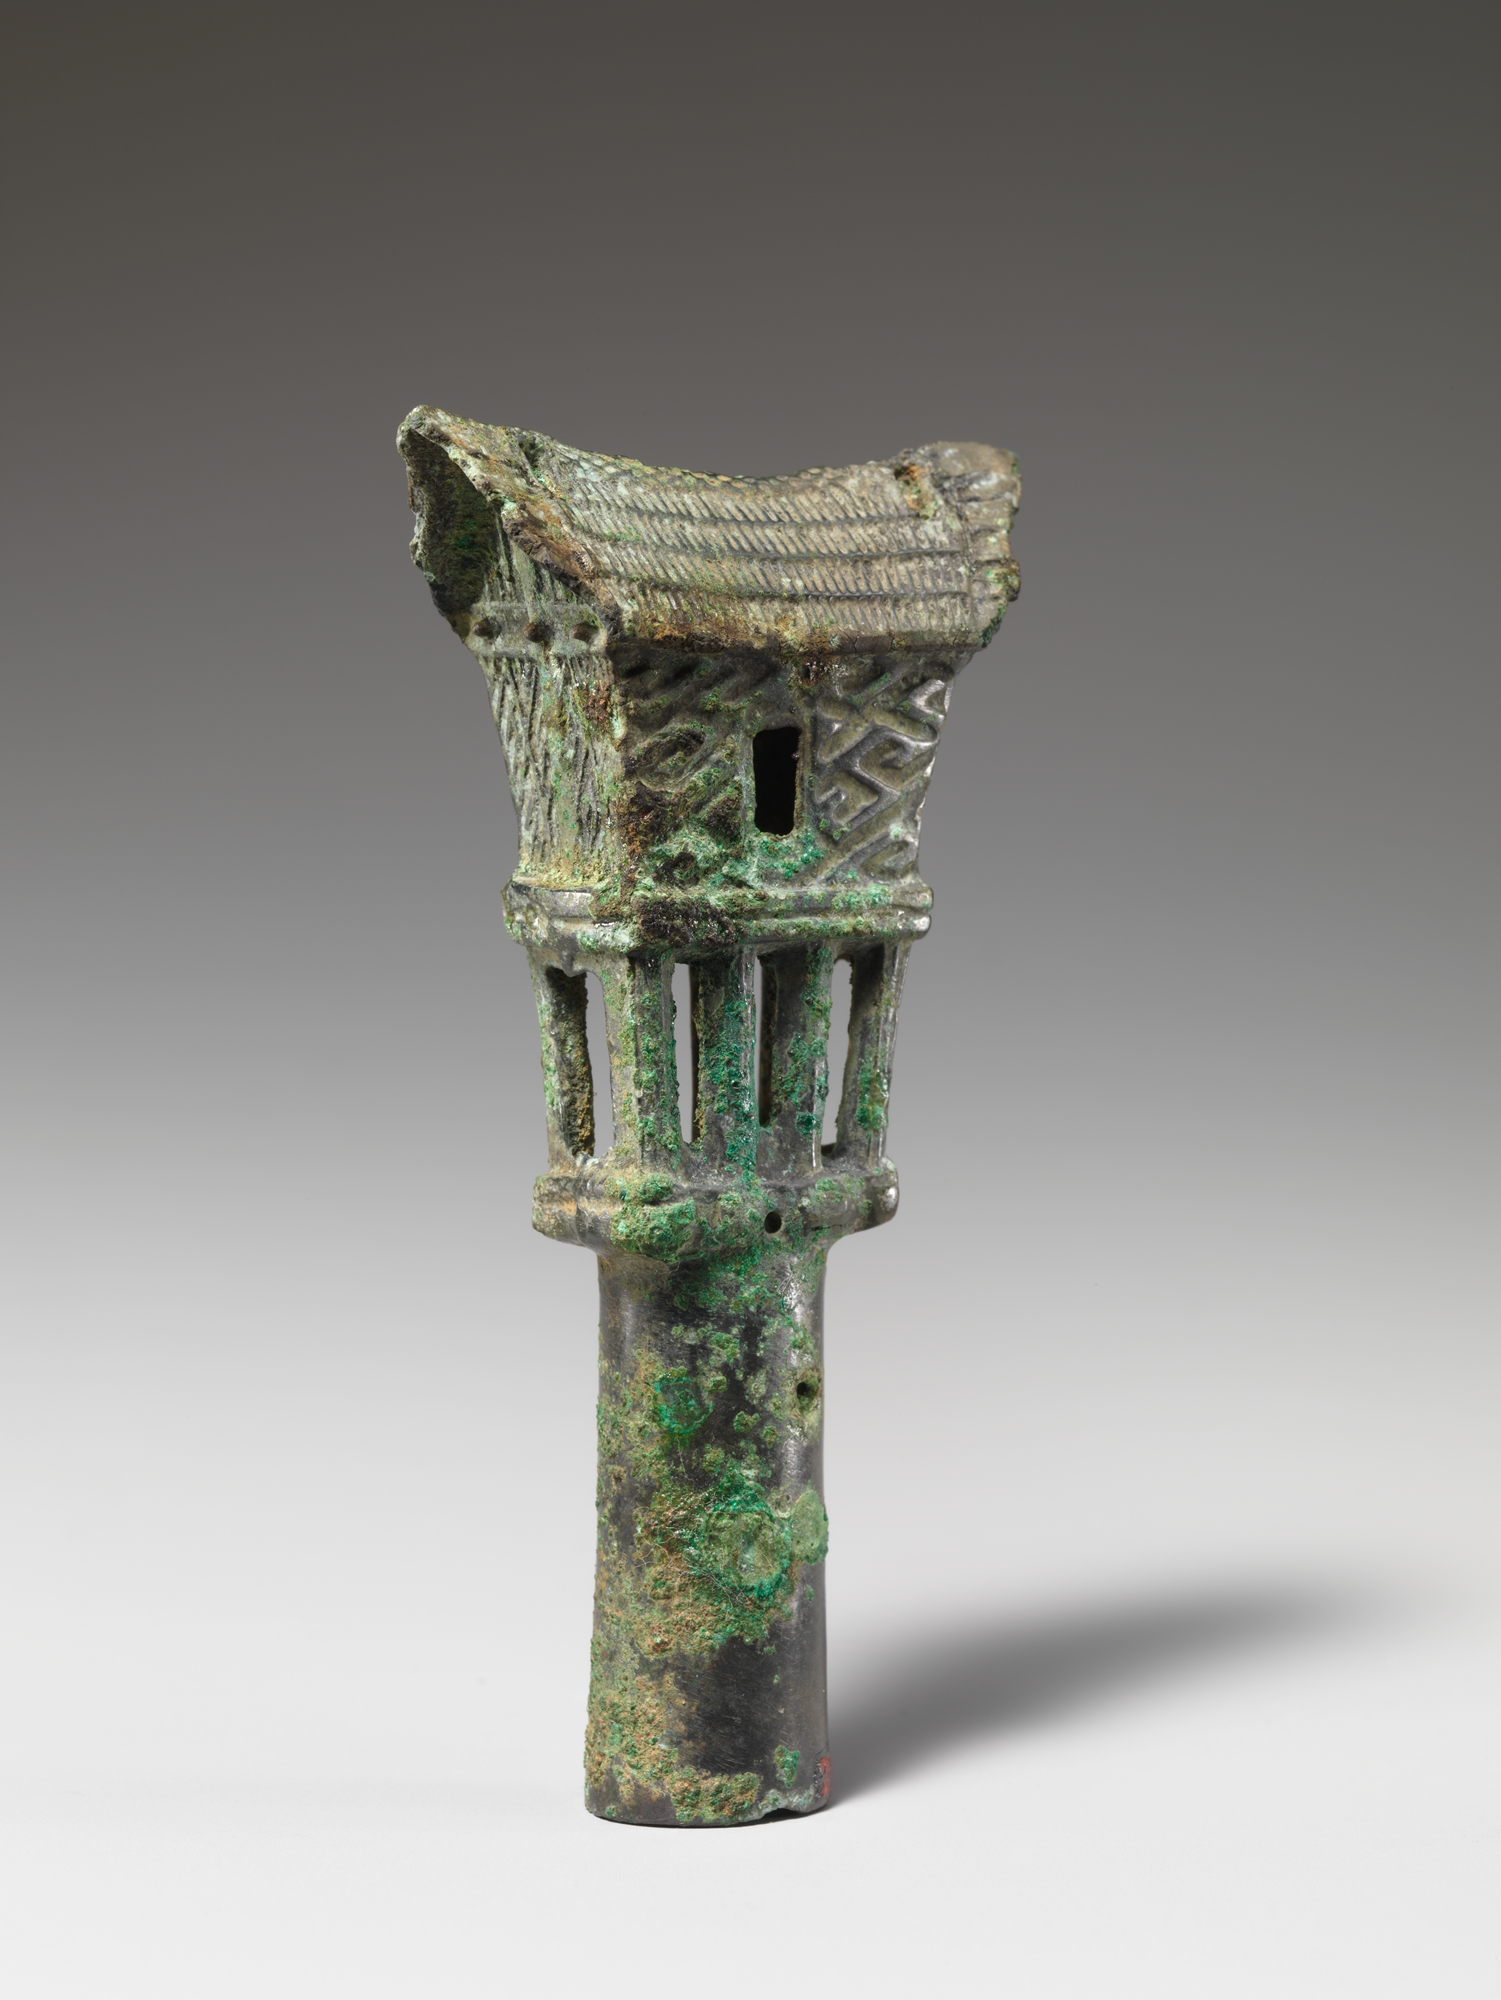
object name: architectural model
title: Model of a Pile Dwelling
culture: chinese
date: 300-1 BCE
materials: bronze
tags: houses